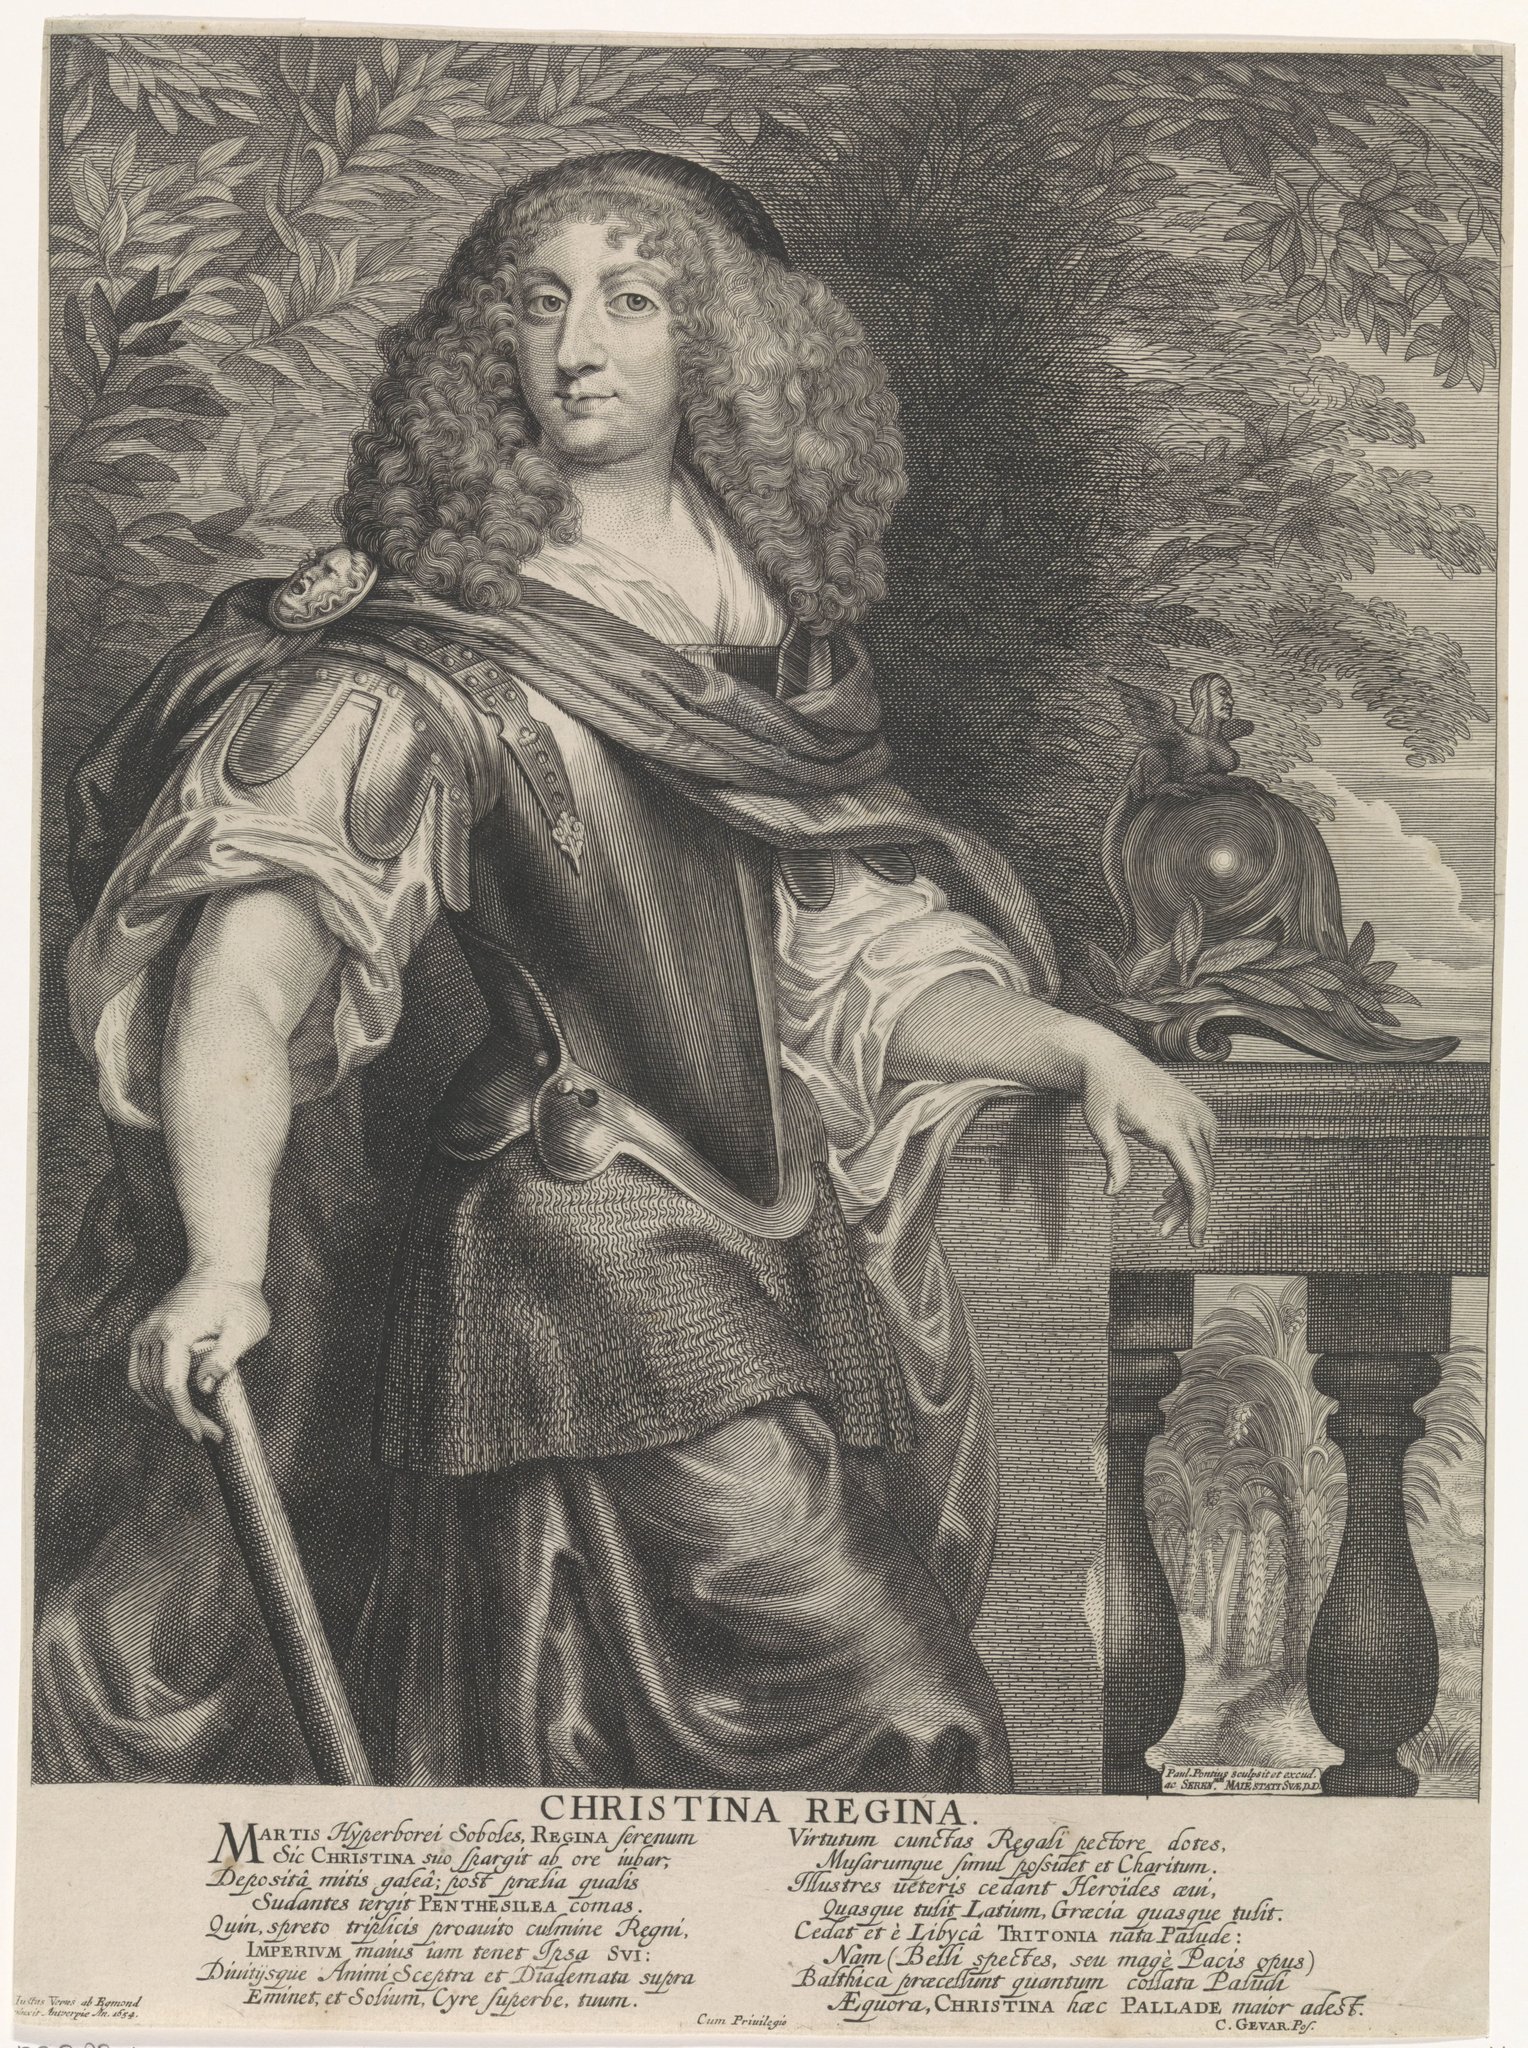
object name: print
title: Allegorisch portret van Christina, koningin van Zweden, als Minerva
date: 1654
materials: paper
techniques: engraving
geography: antwerp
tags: rome, christina (koningin van zweden), (story of) minerva (pallas, athena)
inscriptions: collector's mark: Lugt 2228